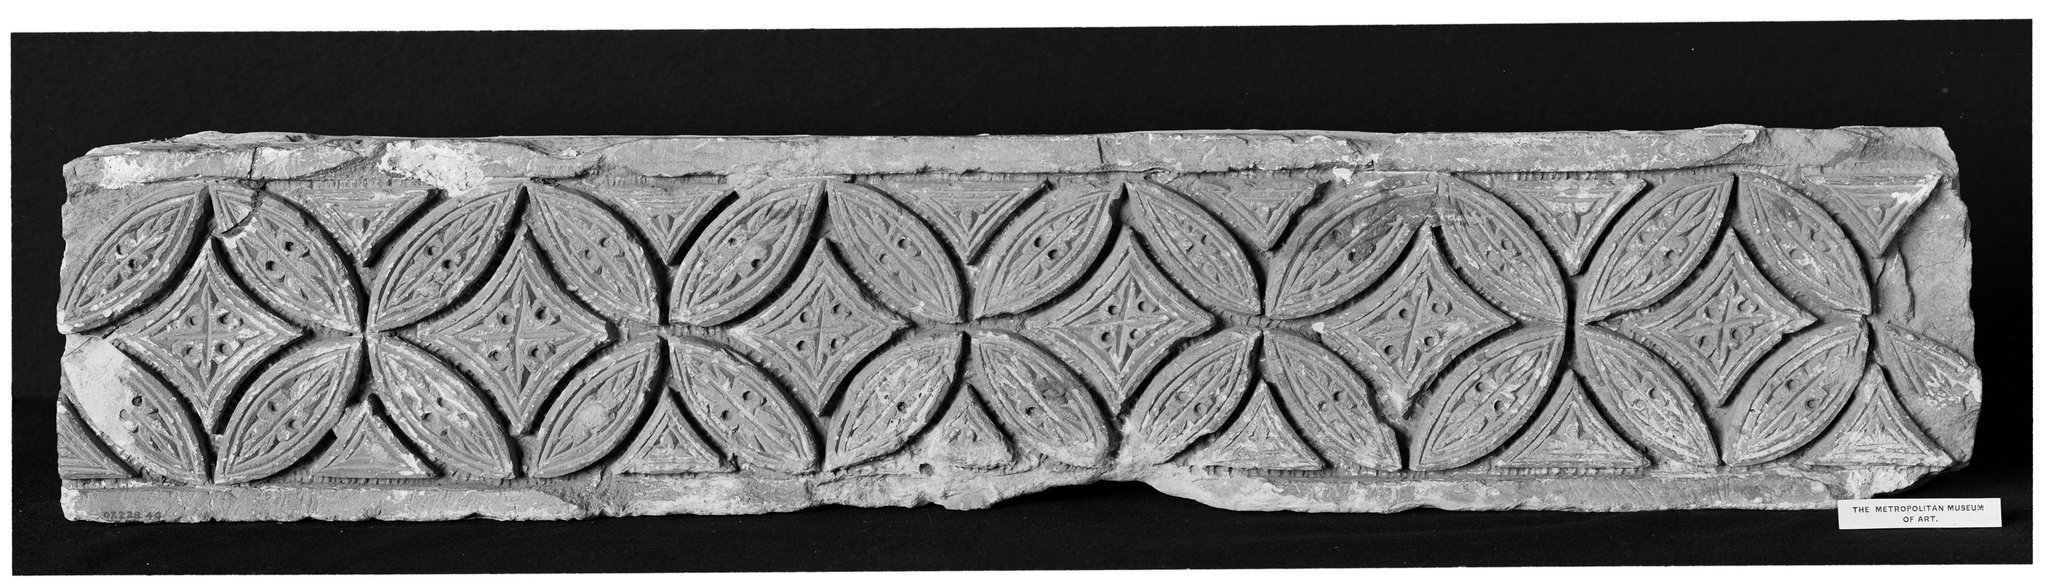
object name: fragment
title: Fragment from a Post or Lintel with Leaves Branching from a Running Vine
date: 501-700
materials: limestone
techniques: carving, relief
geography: egypt